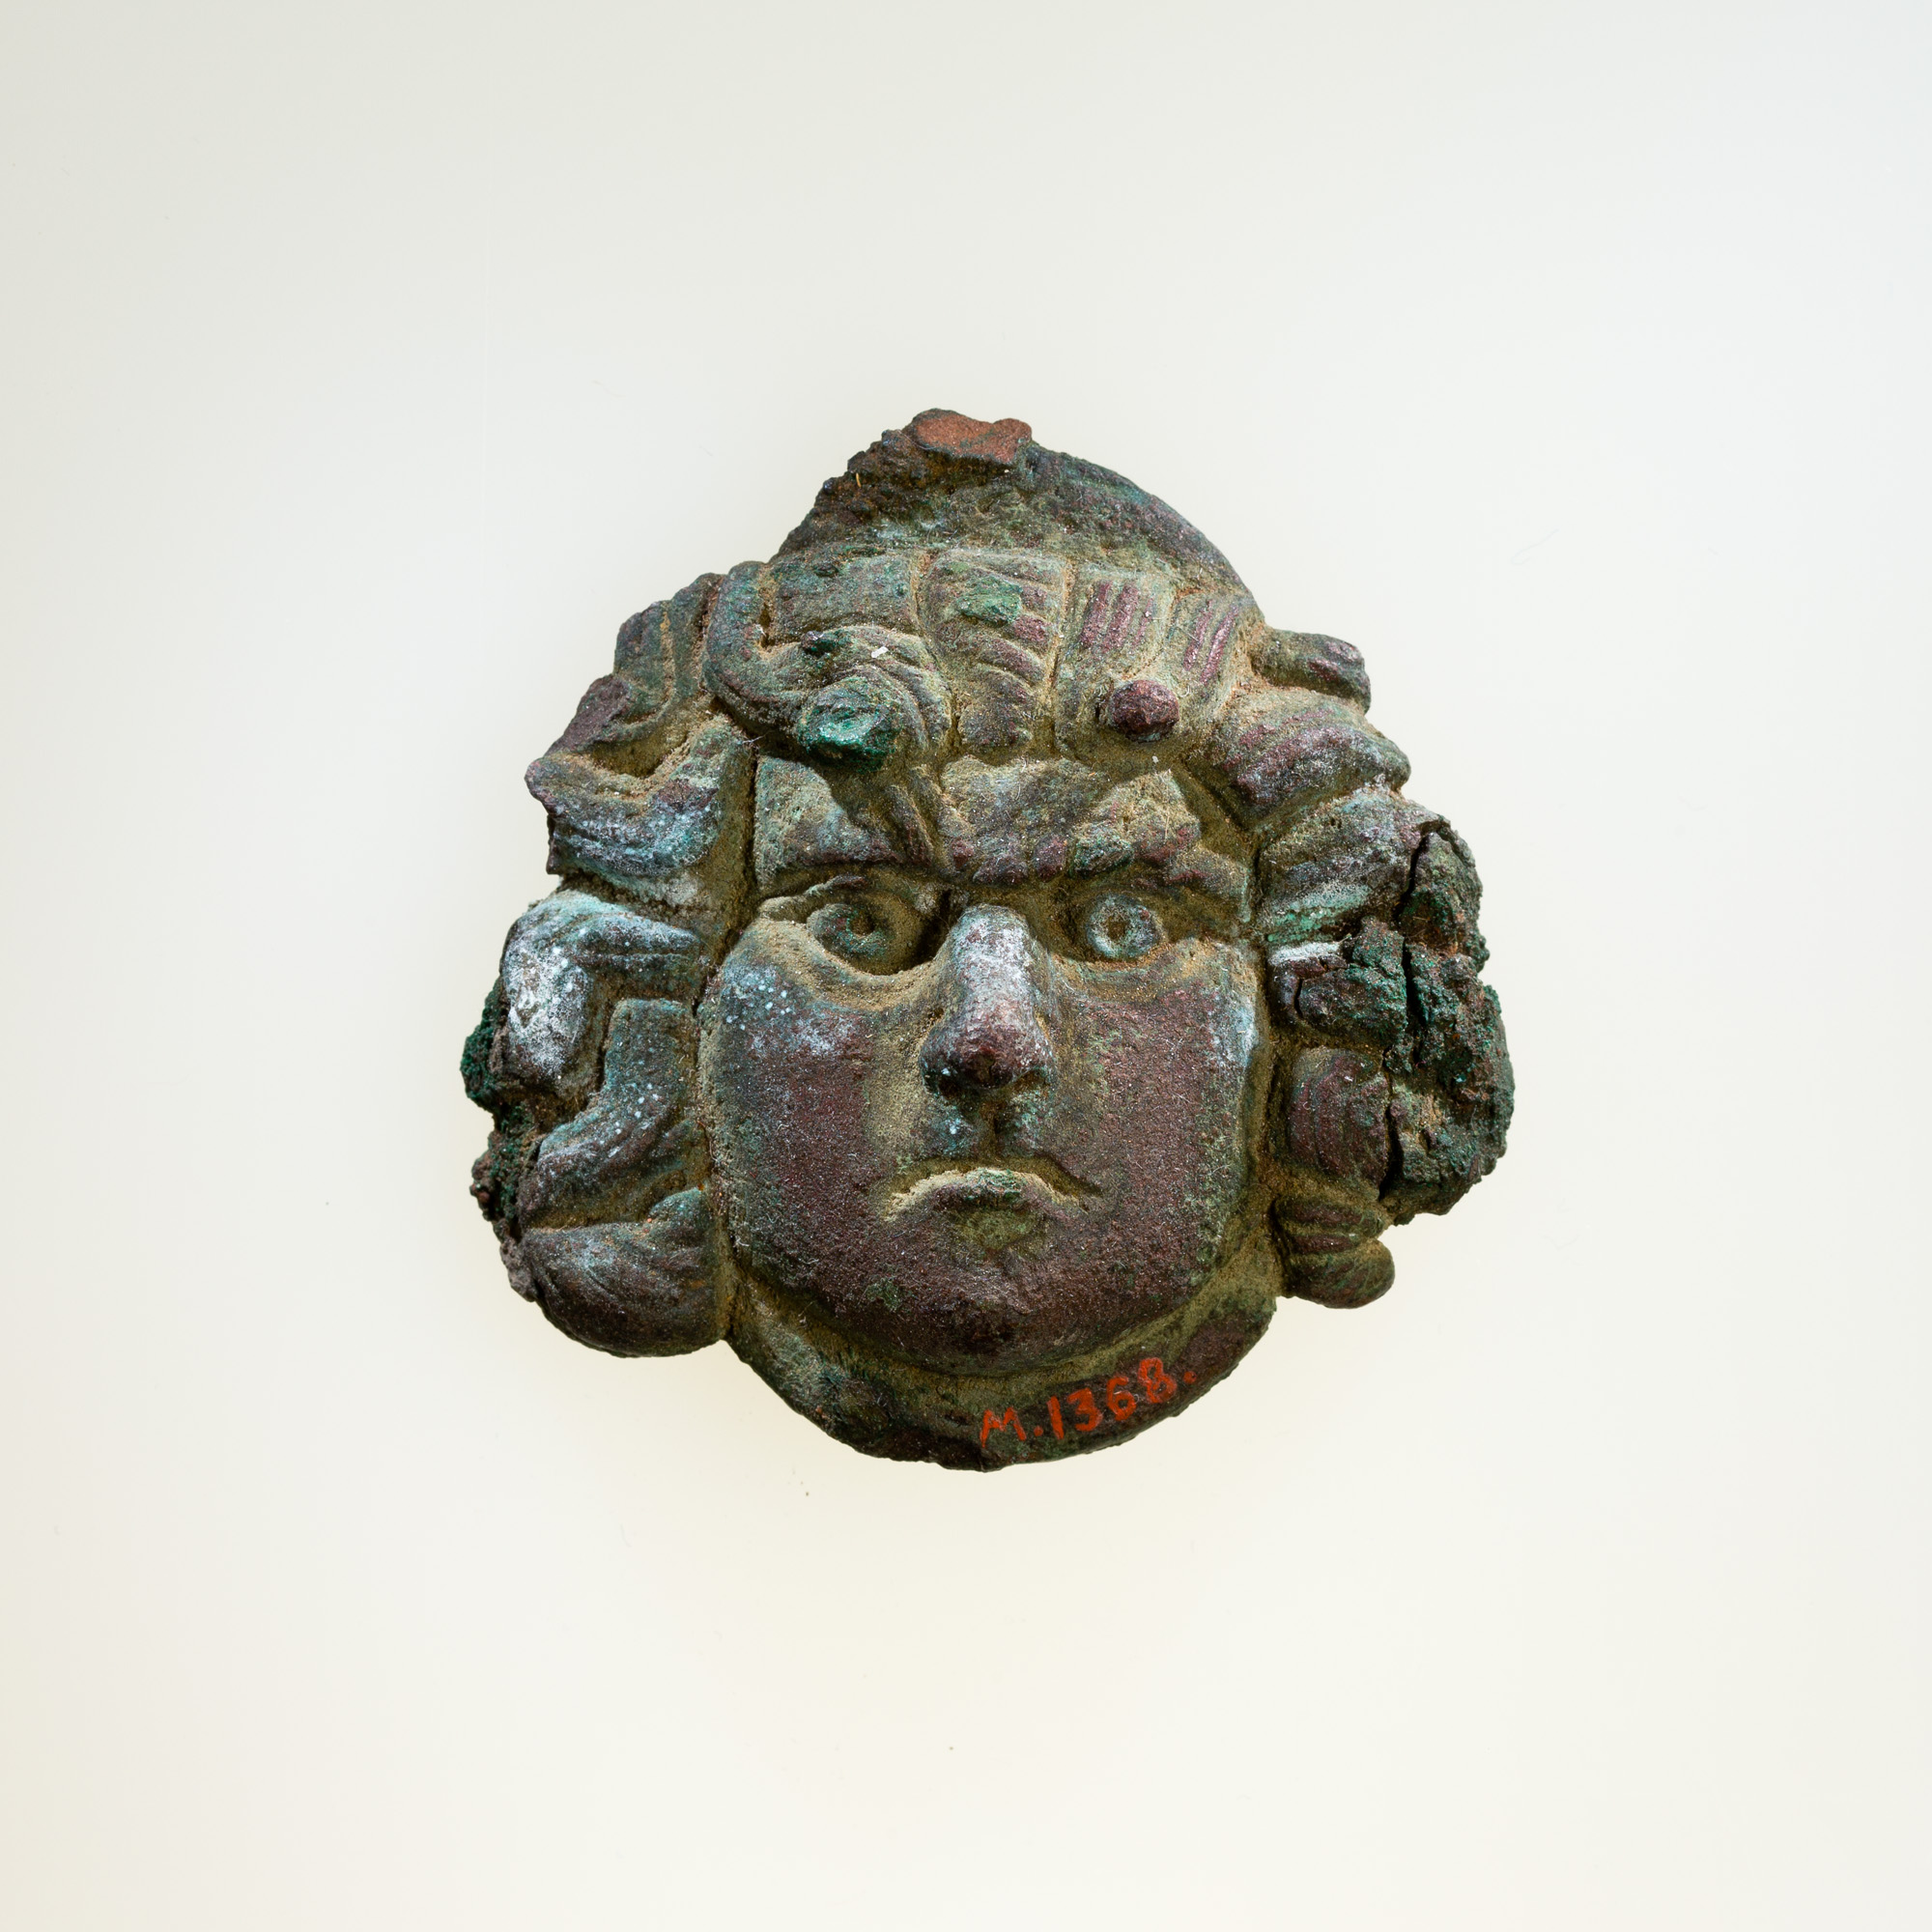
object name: mask, ornamental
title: Ornamental mask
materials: copper alloy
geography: egypt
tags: masks